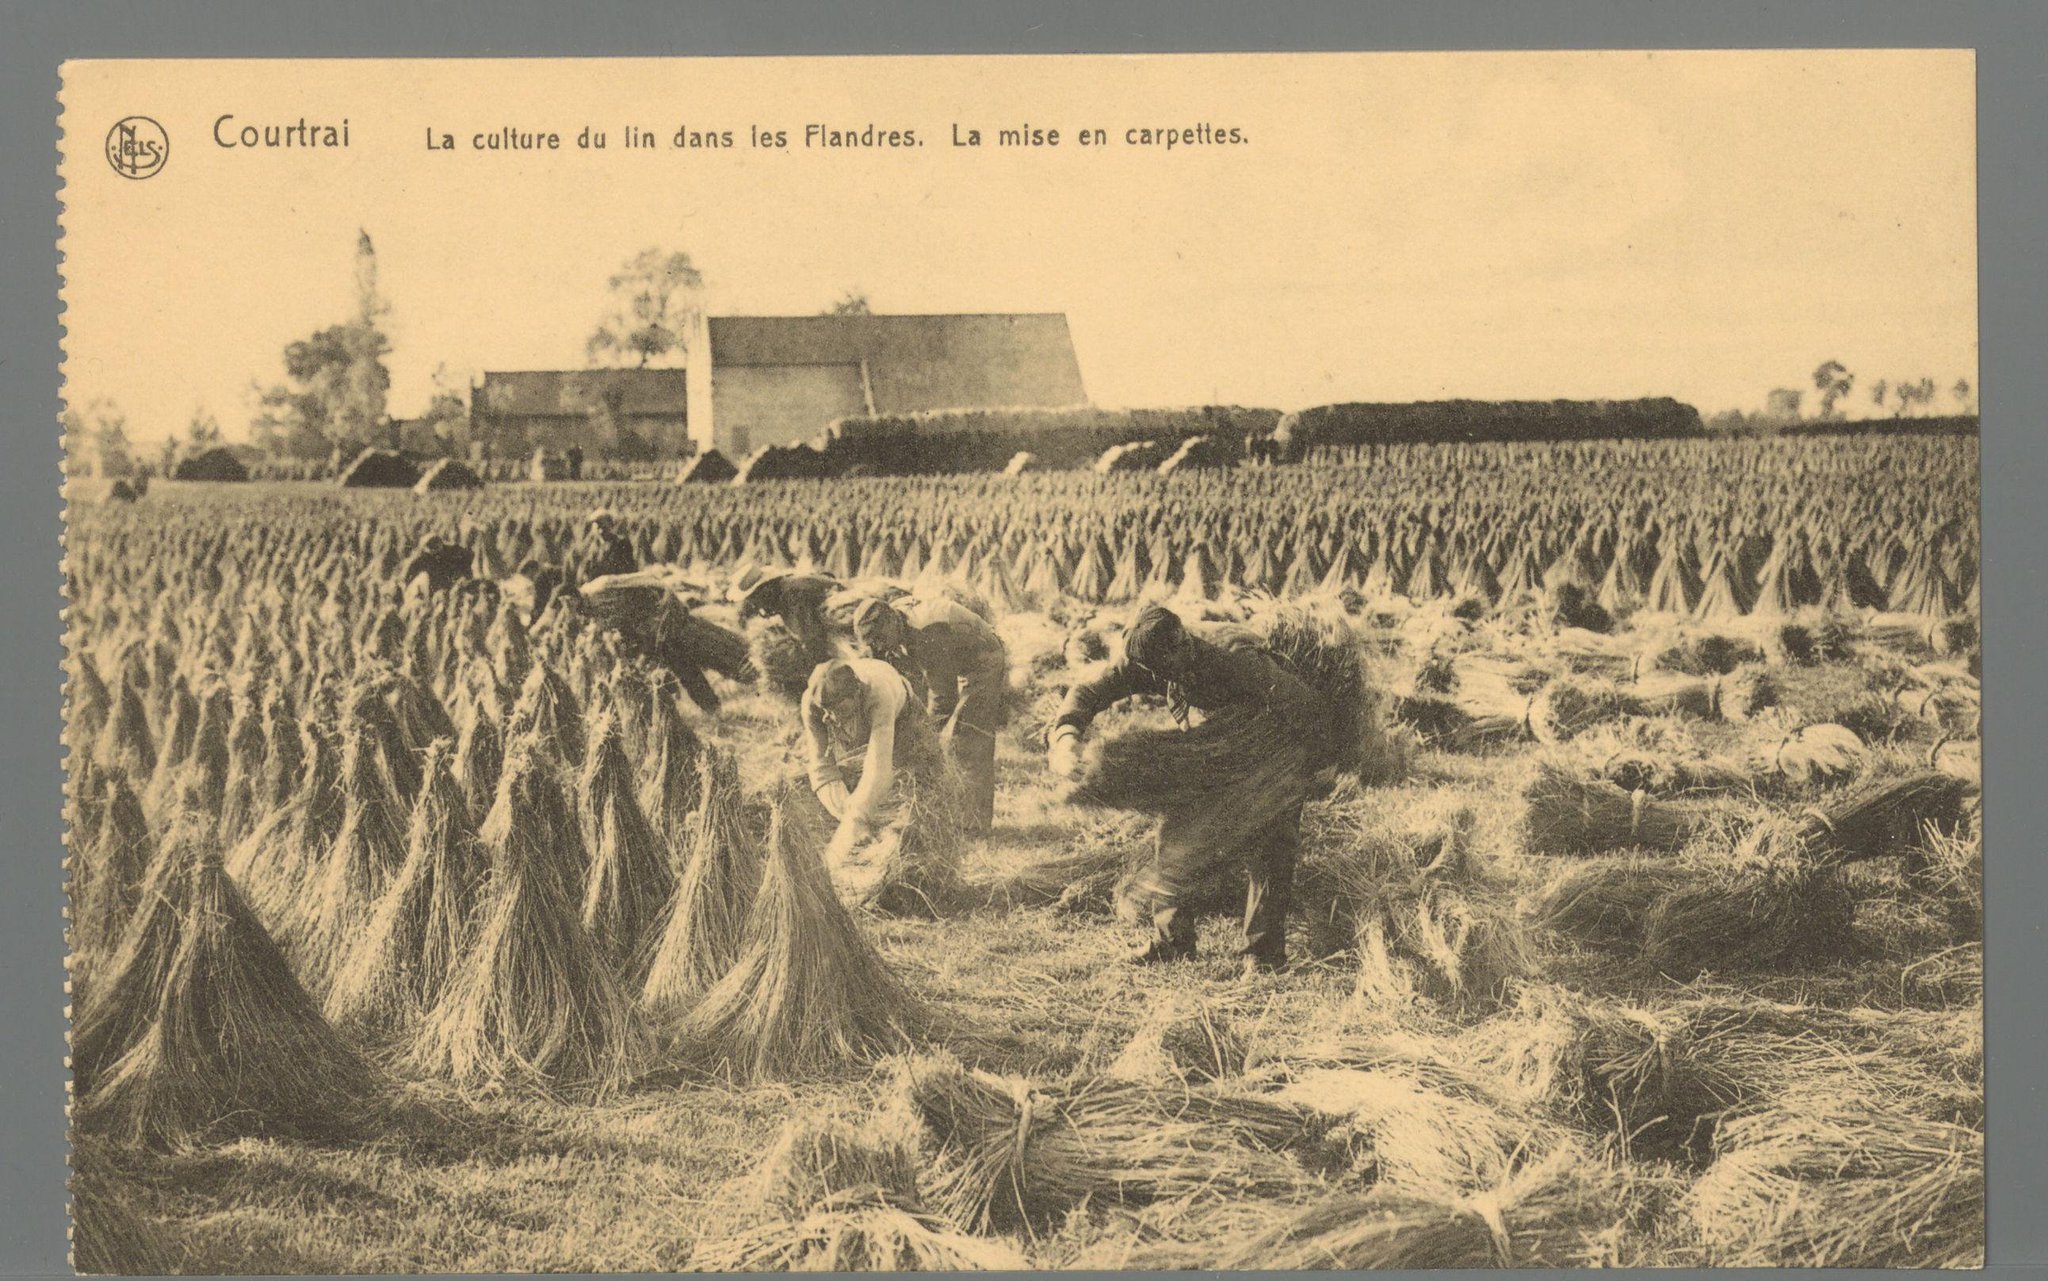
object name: photomechanical print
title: Courtrai. La culture du lin dans les Flandres. La mise en carpettes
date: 1913-1930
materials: cardboard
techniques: photograph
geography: flanders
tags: agriculture (+ labourers ~ crafts, industries, agriculture), linen (material ~ textile industry)